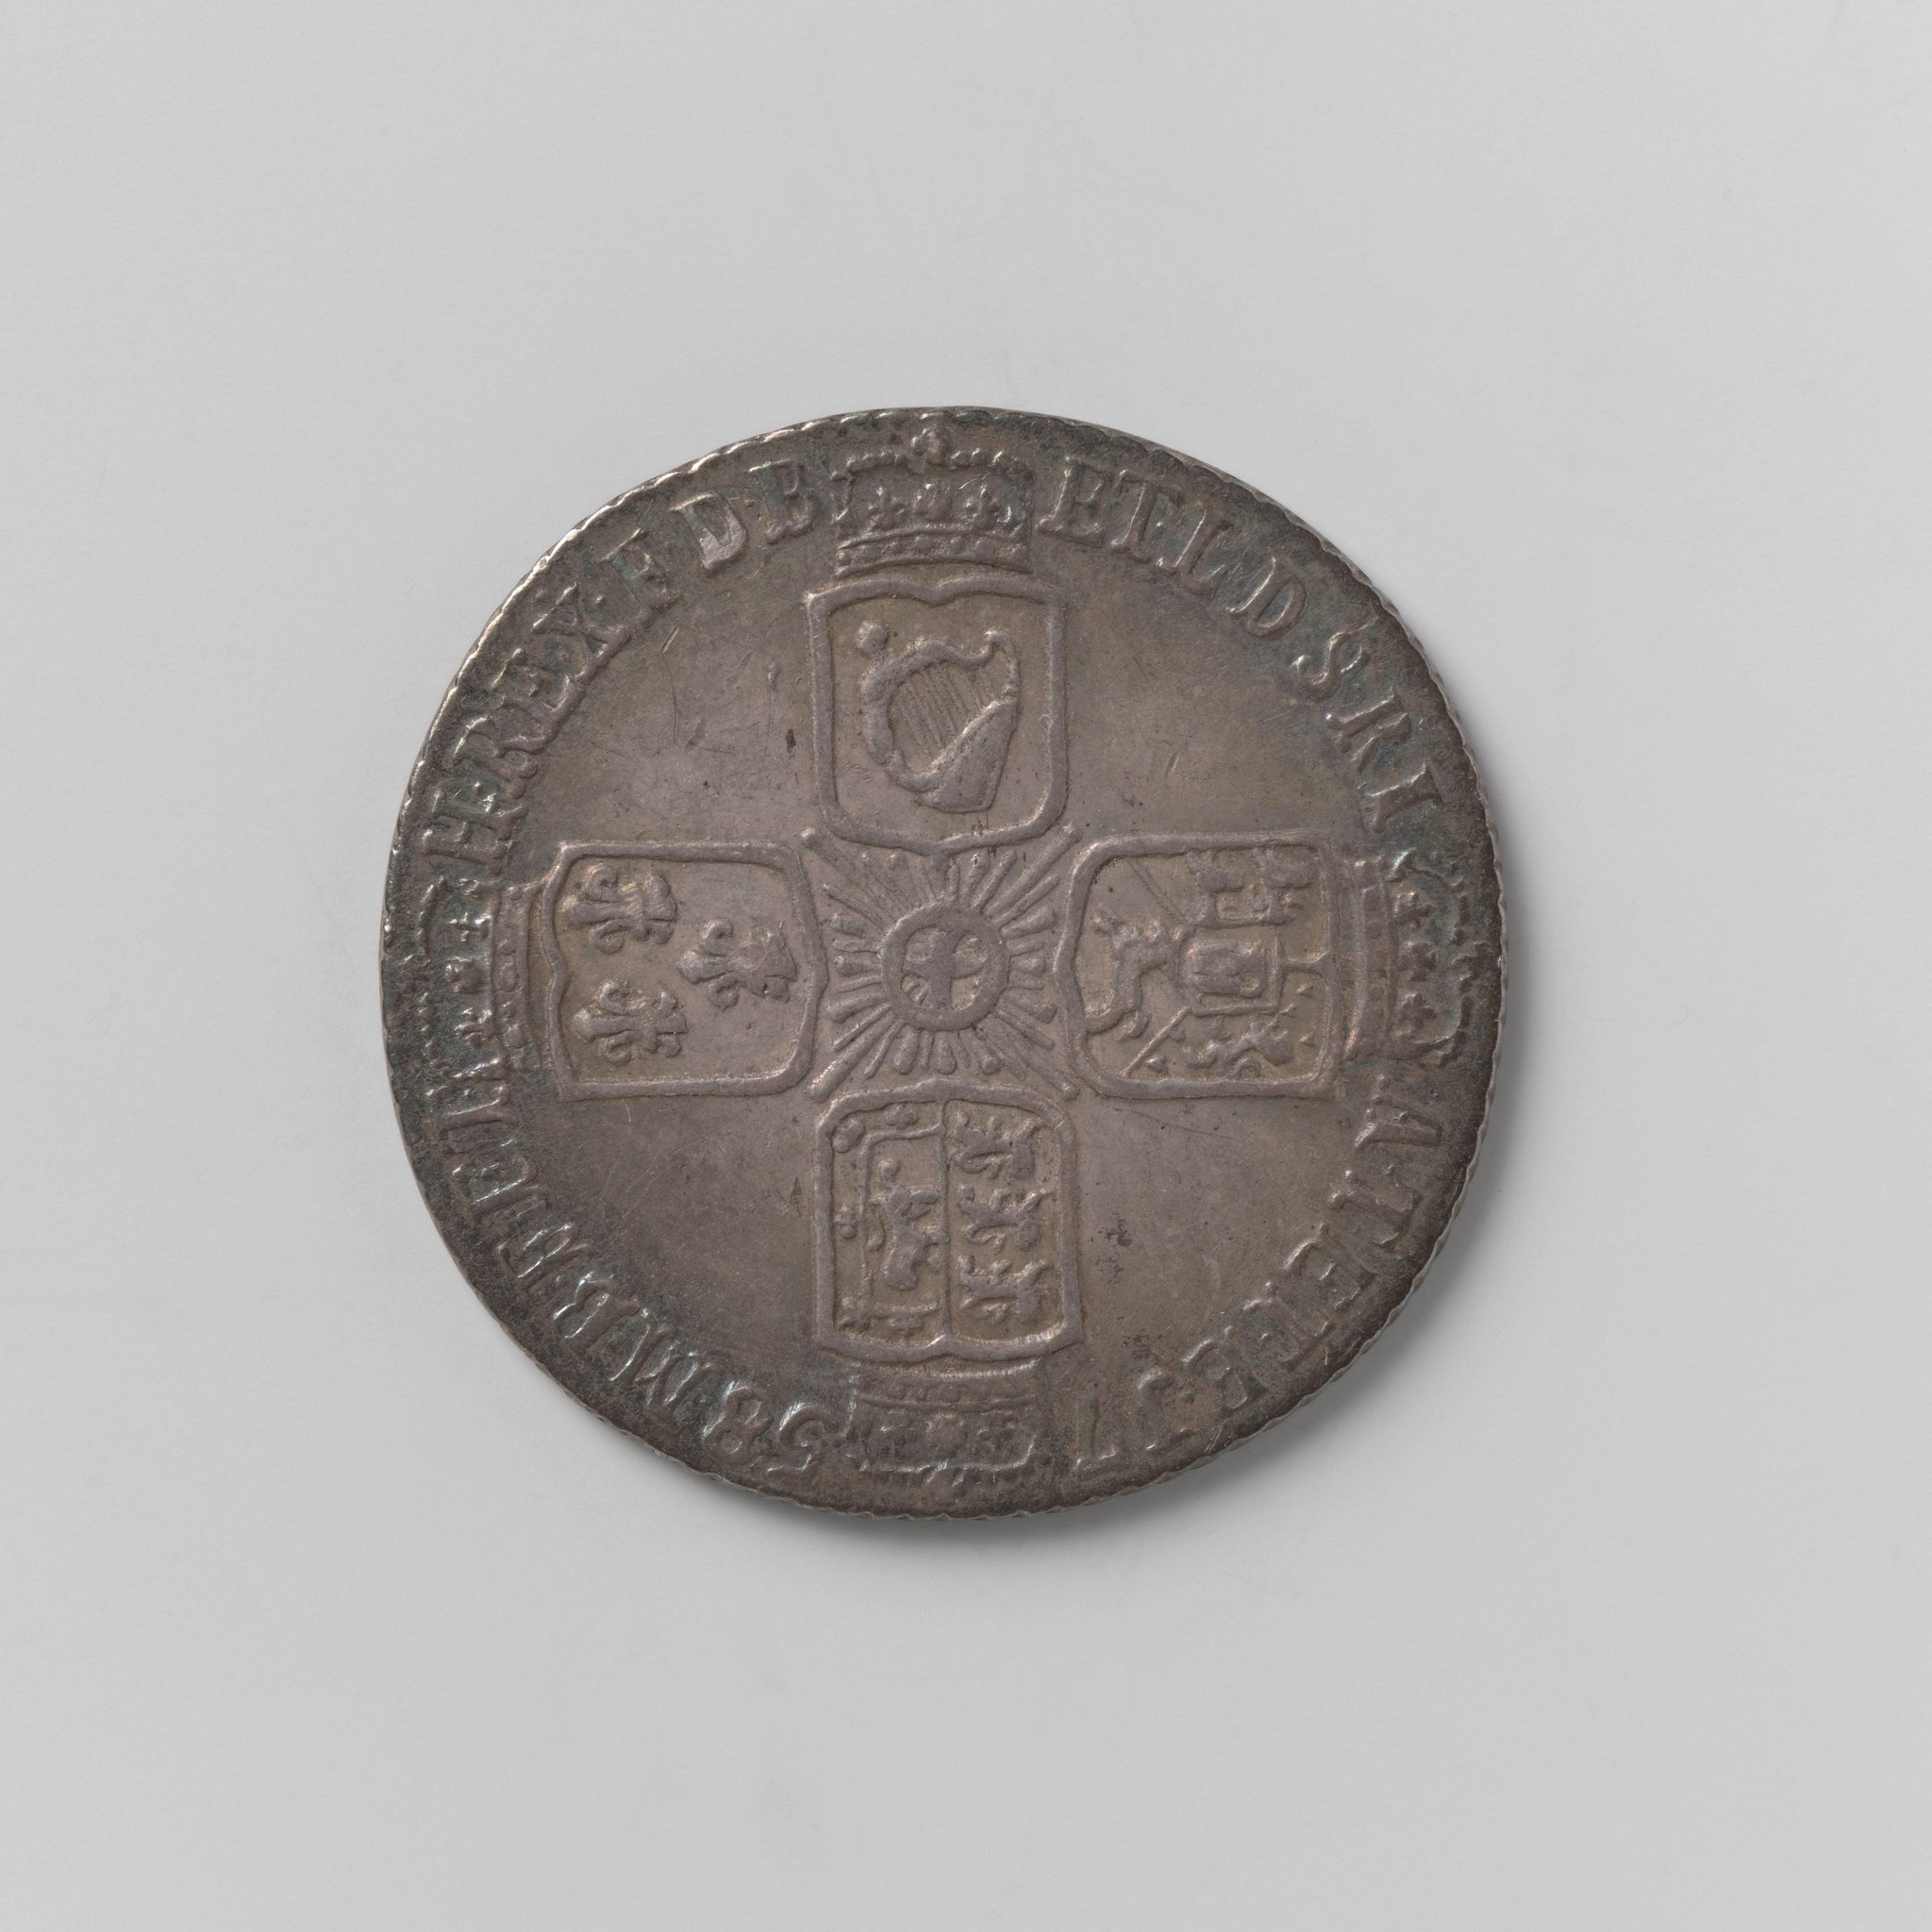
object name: coin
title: 6 pence uit Engeland van George II, 1758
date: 1758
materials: silver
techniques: striking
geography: london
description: Zilveren munt. Voorzijde: gelauwerd borstbeeld van de koning naar links. Keerzijde: rondom kruis binnen cirkel, waaromheen stralen, vier in kruisvorm geplaatste gekroonde wapenschilden. Jaartal bovenaan in omschrift. Kabelrand.